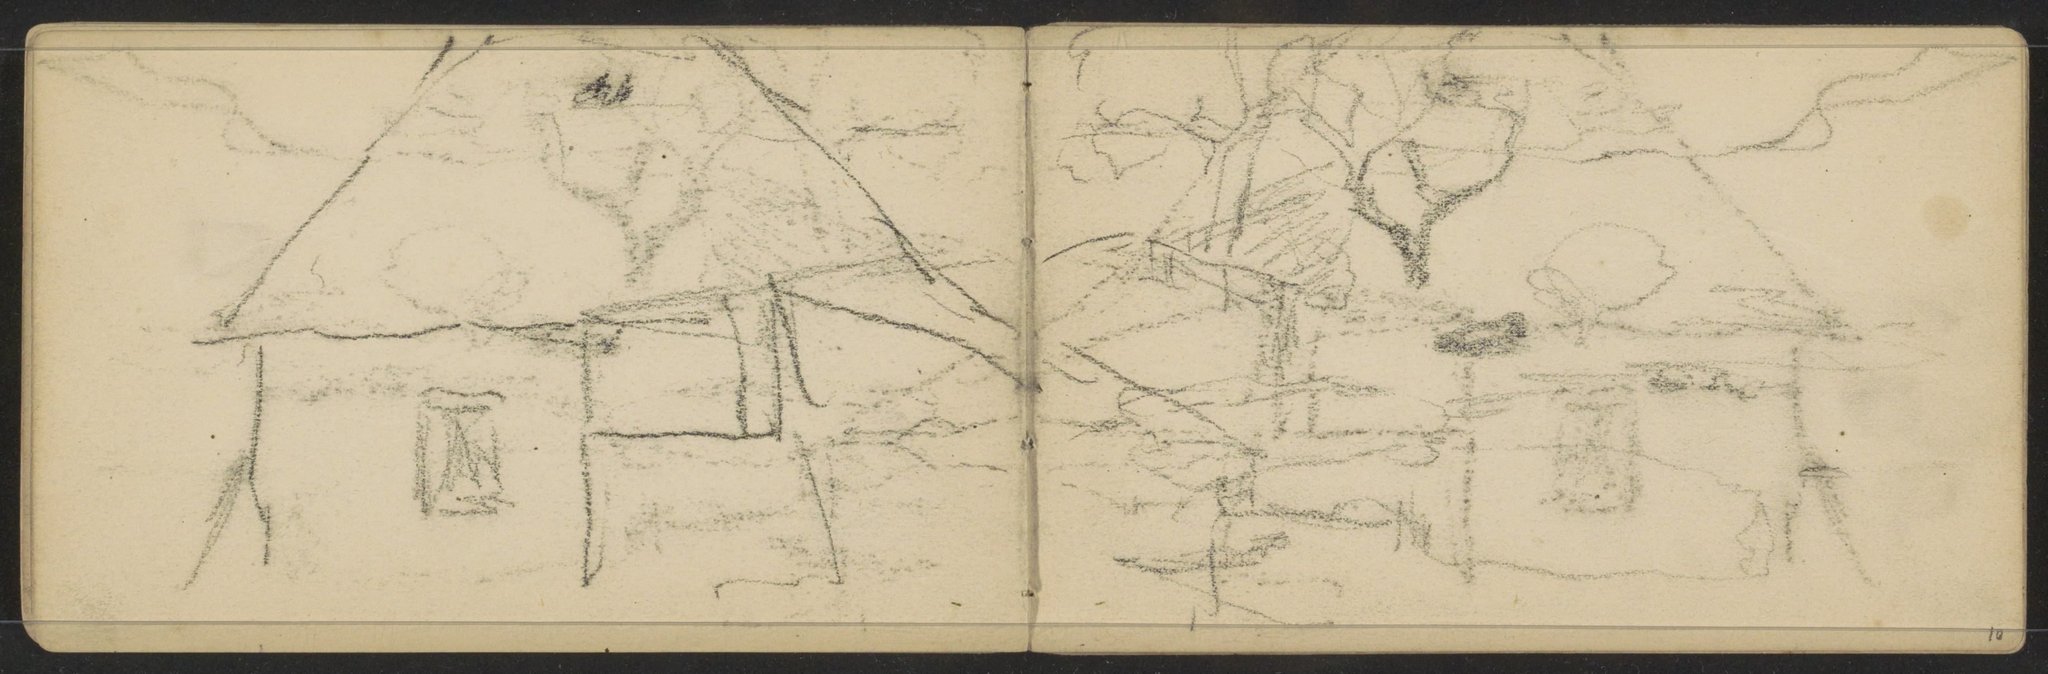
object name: sketchbook leaf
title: Huis met een puntdak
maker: willem cornelis rip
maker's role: draughtsman, painter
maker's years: 1856-1922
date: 1892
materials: chalk, paper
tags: the usual house or row of houses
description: Blad 9 verso en 10 recto uit een schetsboek met 25 bladen.